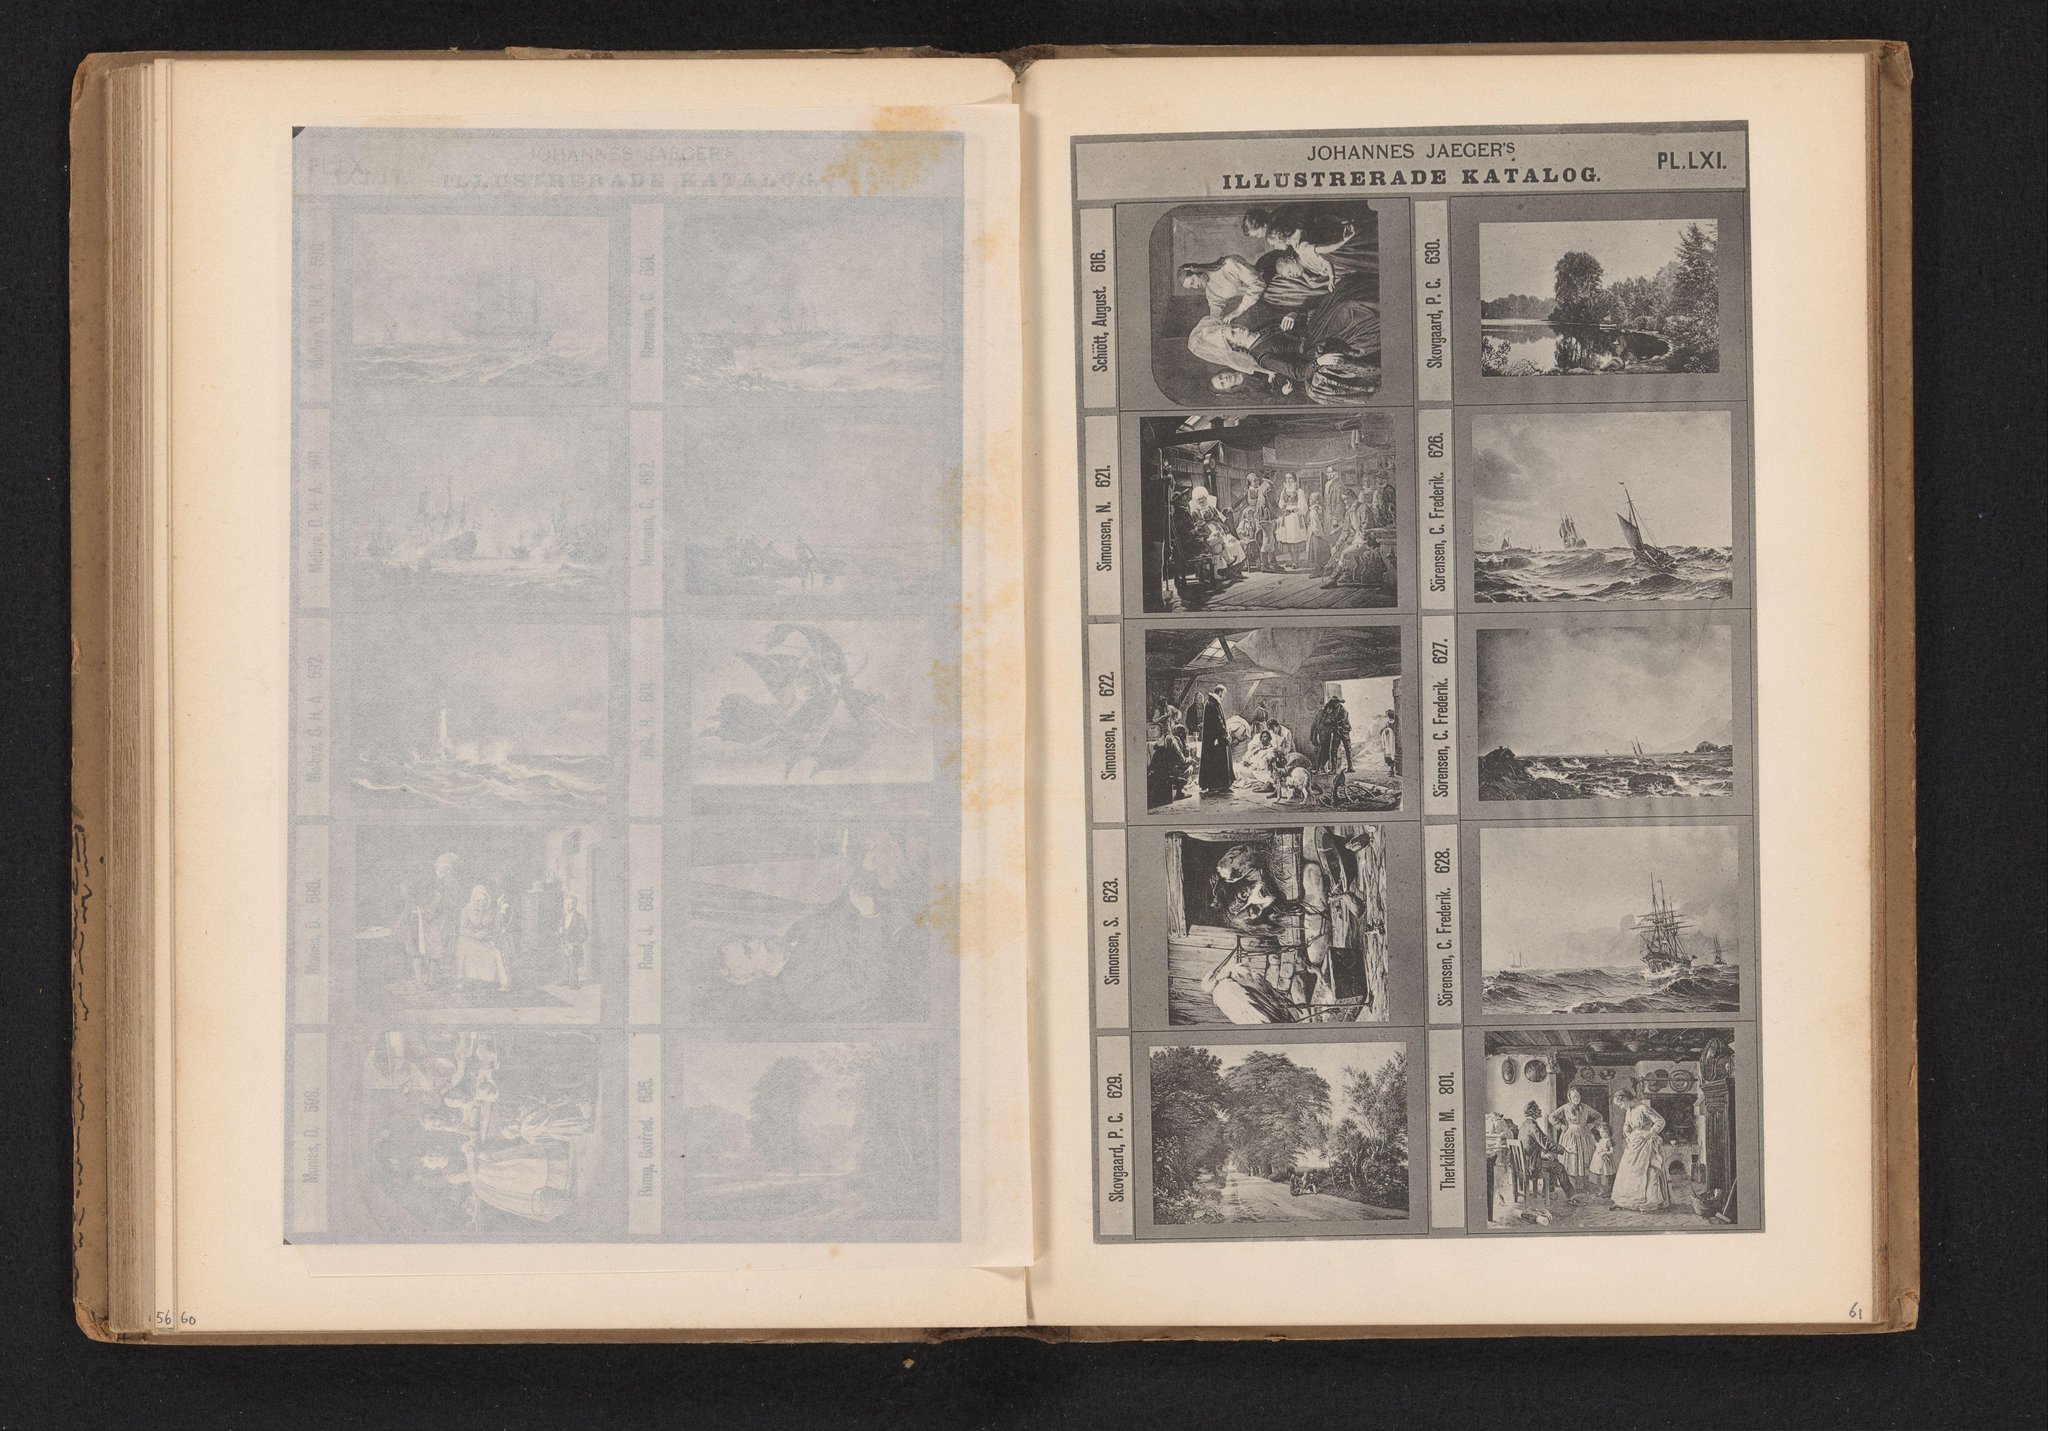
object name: reproduction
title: Johannes Jaeger's Illustrerade Katalog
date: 1872-1882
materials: paper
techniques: photograph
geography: stockholm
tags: picture, painting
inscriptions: number: ‘PL. LXI.’